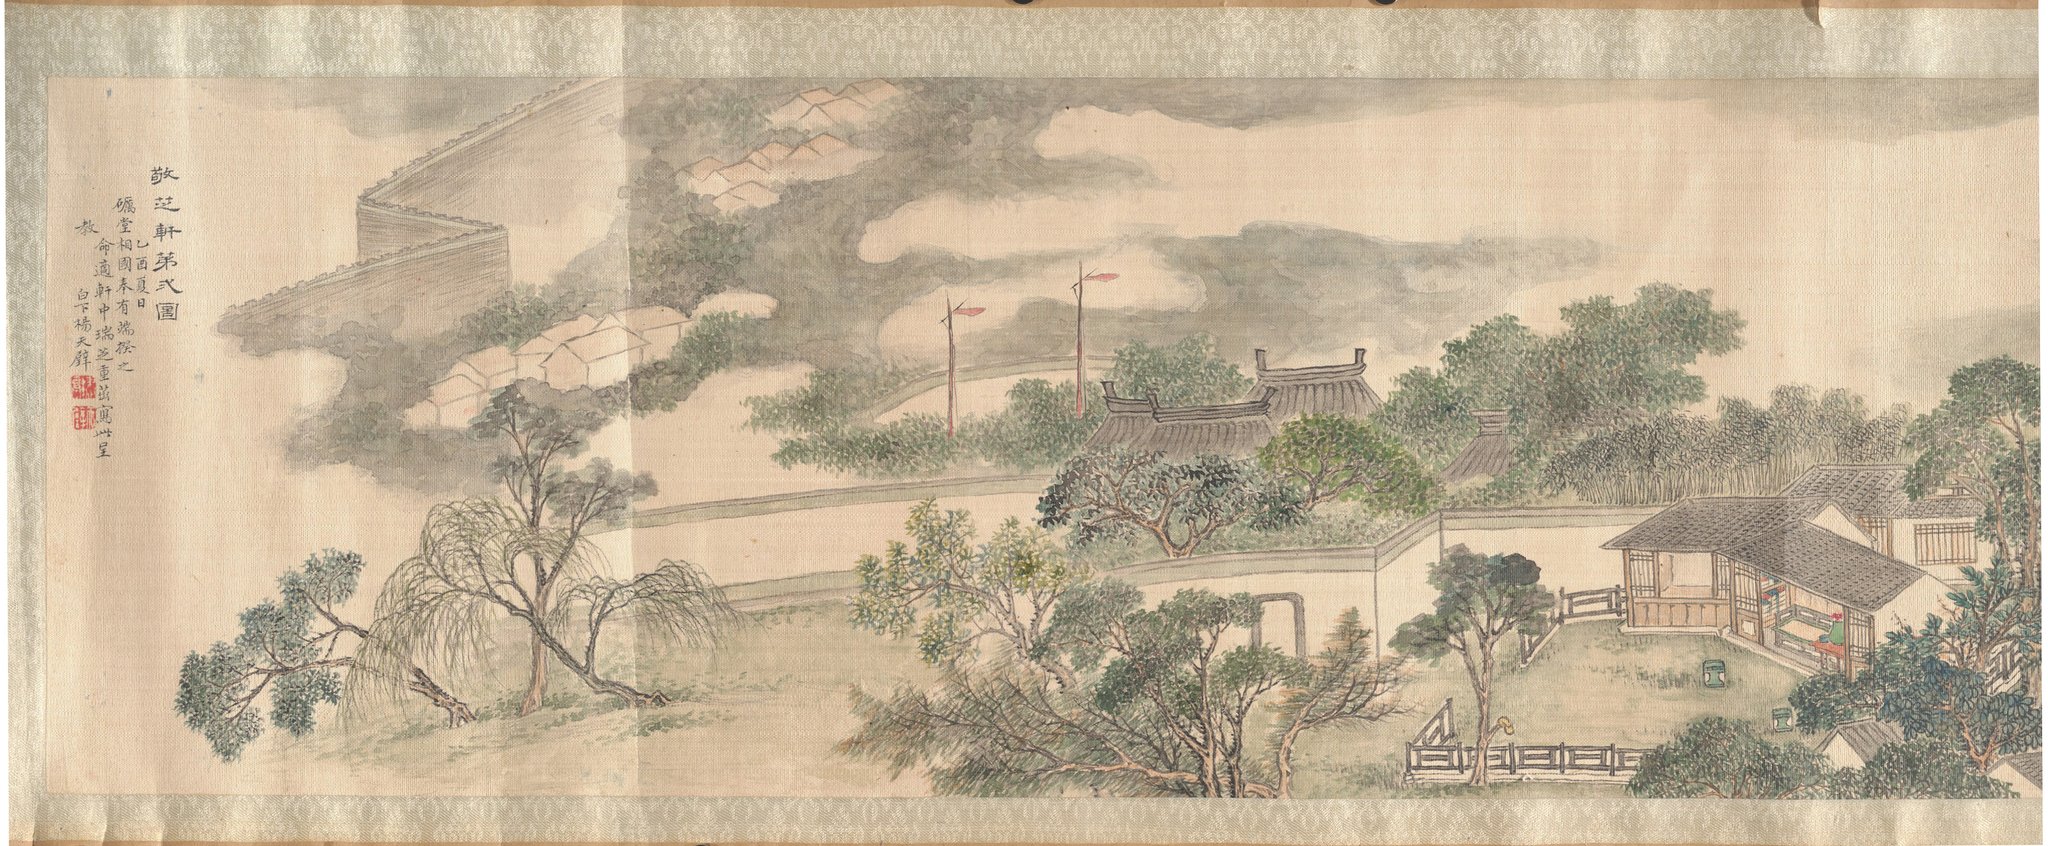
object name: handscroll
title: Second View of the Studio for Respecting the Fungus of Longevity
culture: chinese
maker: yang tianbi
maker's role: artist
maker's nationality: chinese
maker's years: 1800-1833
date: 1825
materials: ink, silk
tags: landscapes,trees